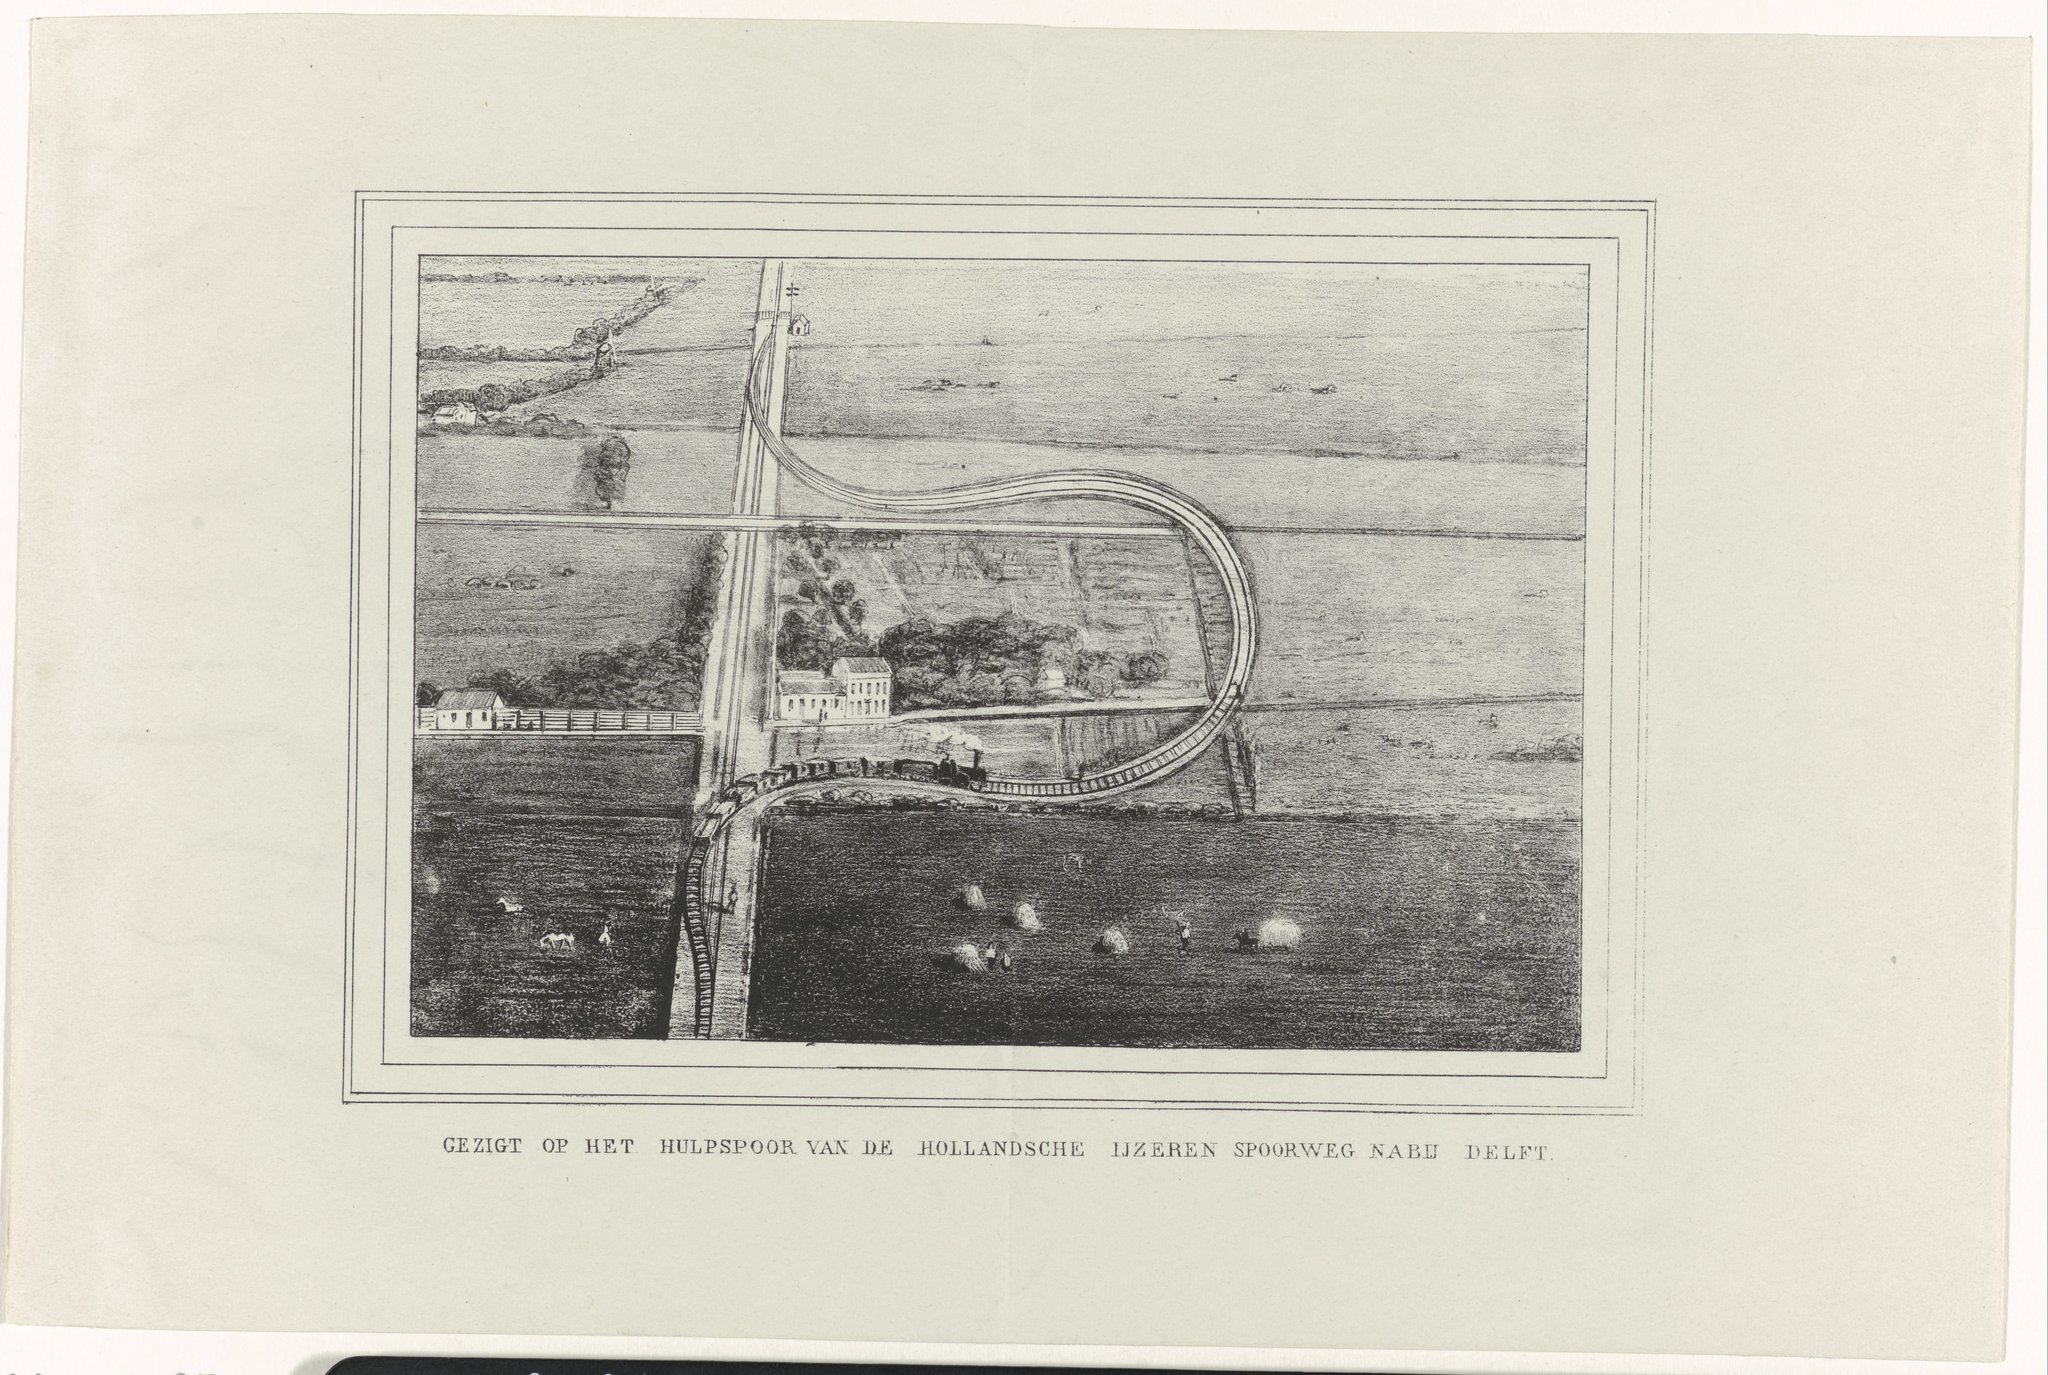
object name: print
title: Gezigt op het hulpspoor van de Hollandsche IJzeren Spoorweg nabij Delft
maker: Anonymous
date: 1847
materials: paper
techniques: lithograph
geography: netherlands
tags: railway, train, delft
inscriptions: collector's mark: Lugt 2228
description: Gezicht op het zogenaamde Laantje van Van der Gaag, een omleiding in de spoorlijn tussen Delft en Schiedam. Omdat Van der Gaag zijn land weigerde af te staan moest de spoorlijn in een grote bocht om het perceel worden aangelegd. Aan dit geval dankt de Onteigeningswet haar oorsprong. Het proces over deze zaak werd in juni 1847 beslist.